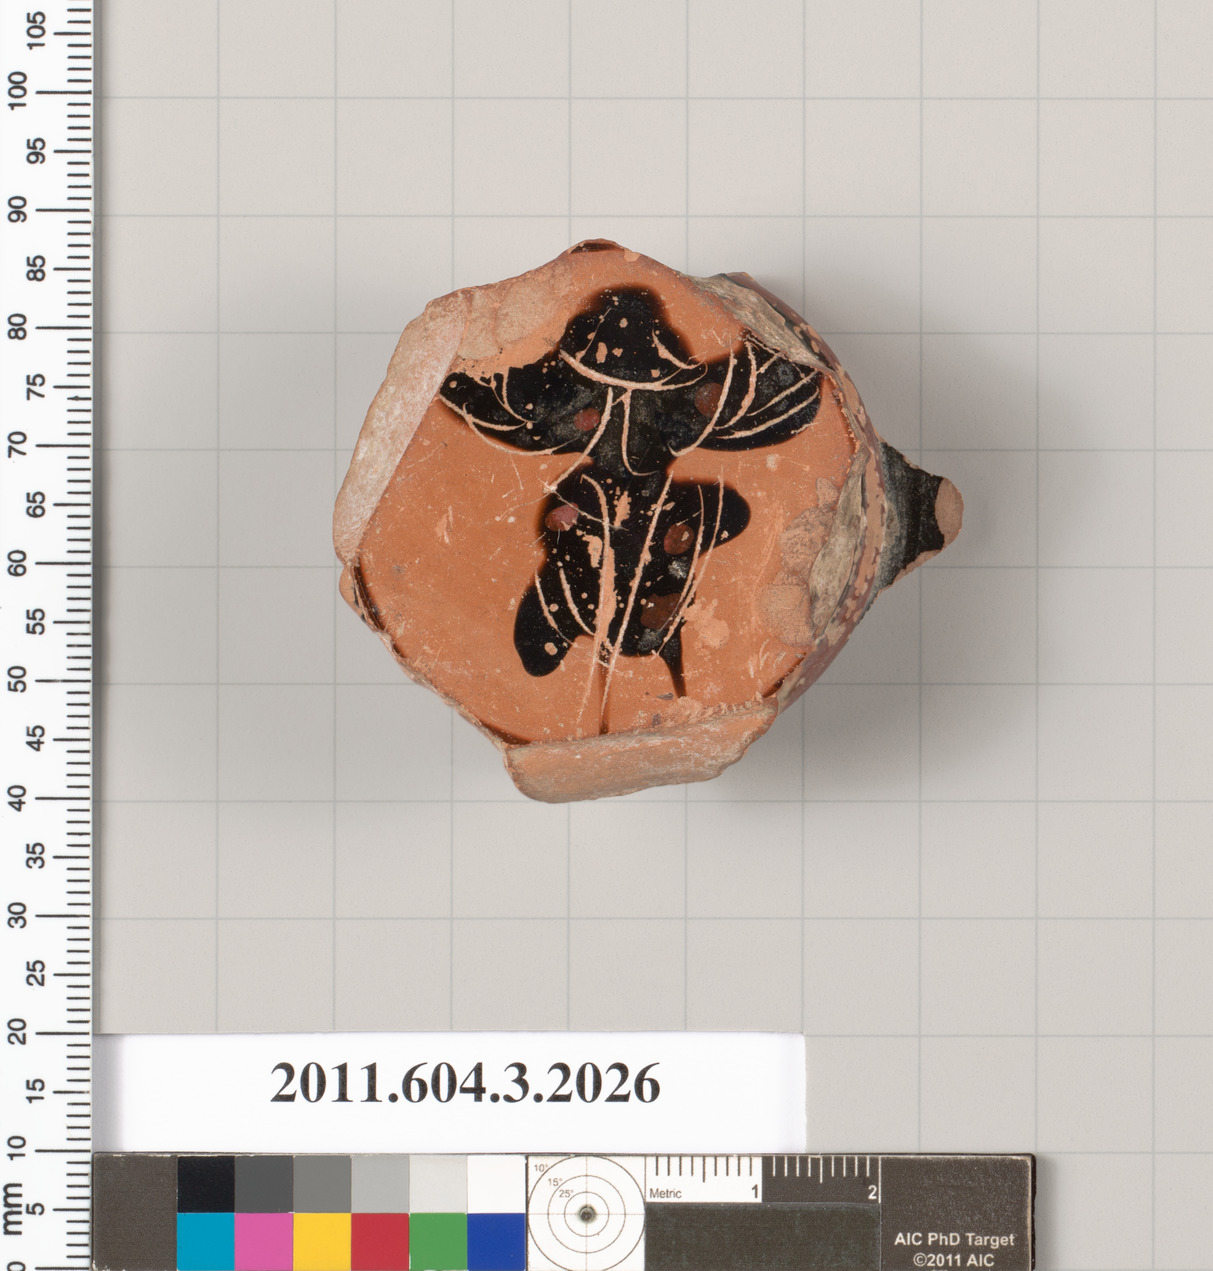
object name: kylix fragment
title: Terracotta fragment of a kylix (drinking cup)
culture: greek, attic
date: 534-468 BCE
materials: terracotta